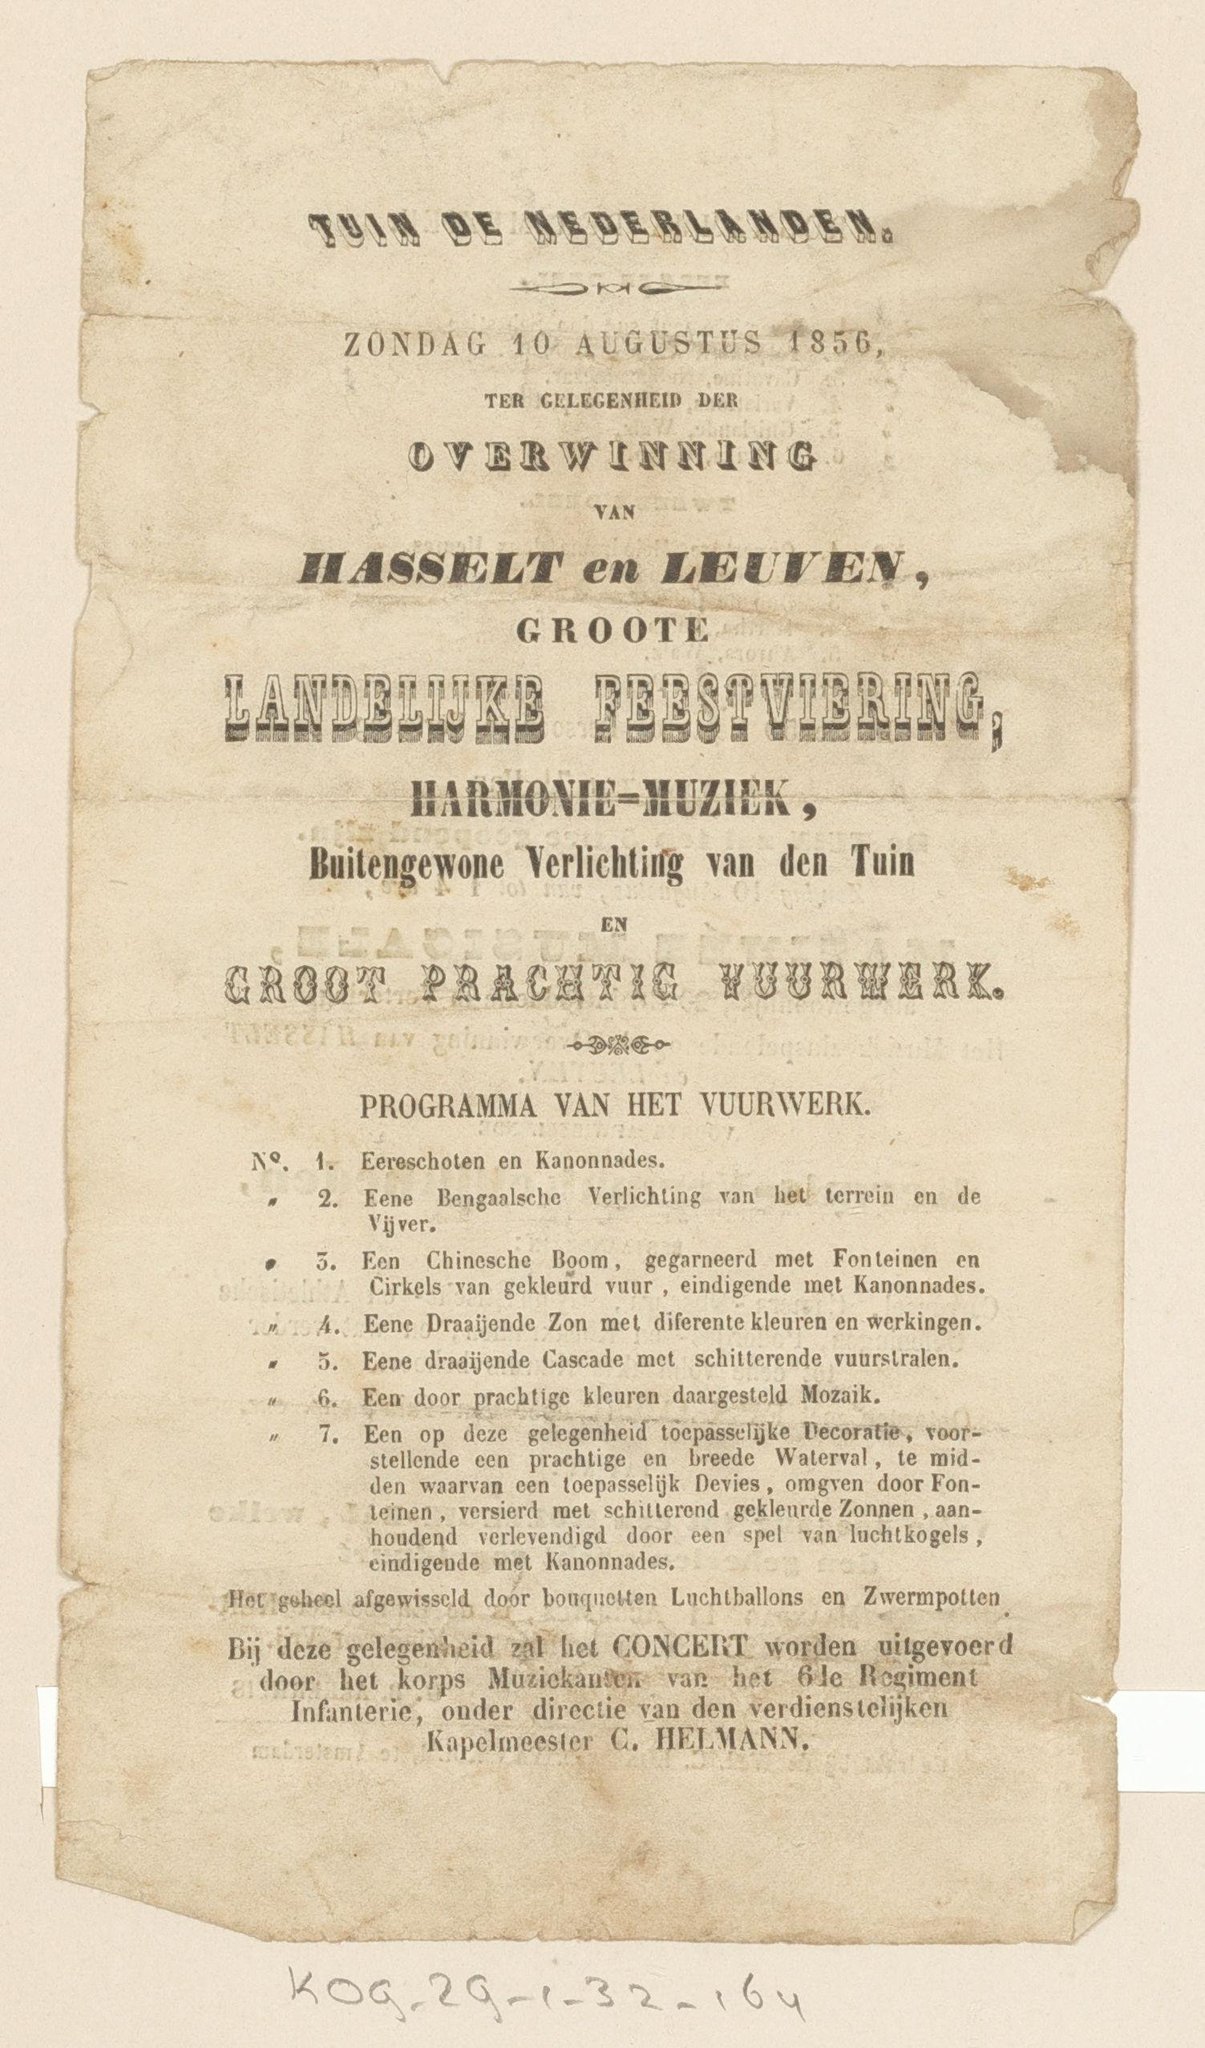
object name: programma, programmaboekje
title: Tuin De Nederlanden. Zondag 10 augustus 1856, ter gelegenheid der overwinning van Hasselt en Leuven, groote Landelijke Feestviering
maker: weduwe c. kok geboren van kolm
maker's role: printer, publisher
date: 1856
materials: paper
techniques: letterpress printing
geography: amsterdam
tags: listening to music - cc - out of doors, military band, pleasure fair and circus, amsterdam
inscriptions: collector's mark: Lugt 1641, collector's mark